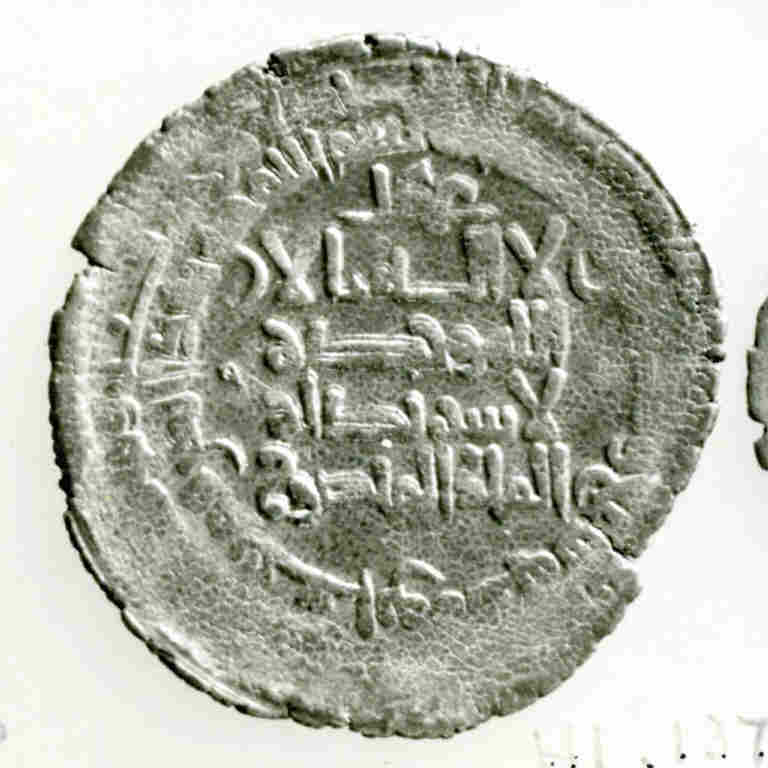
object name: coin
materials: silver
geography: iran